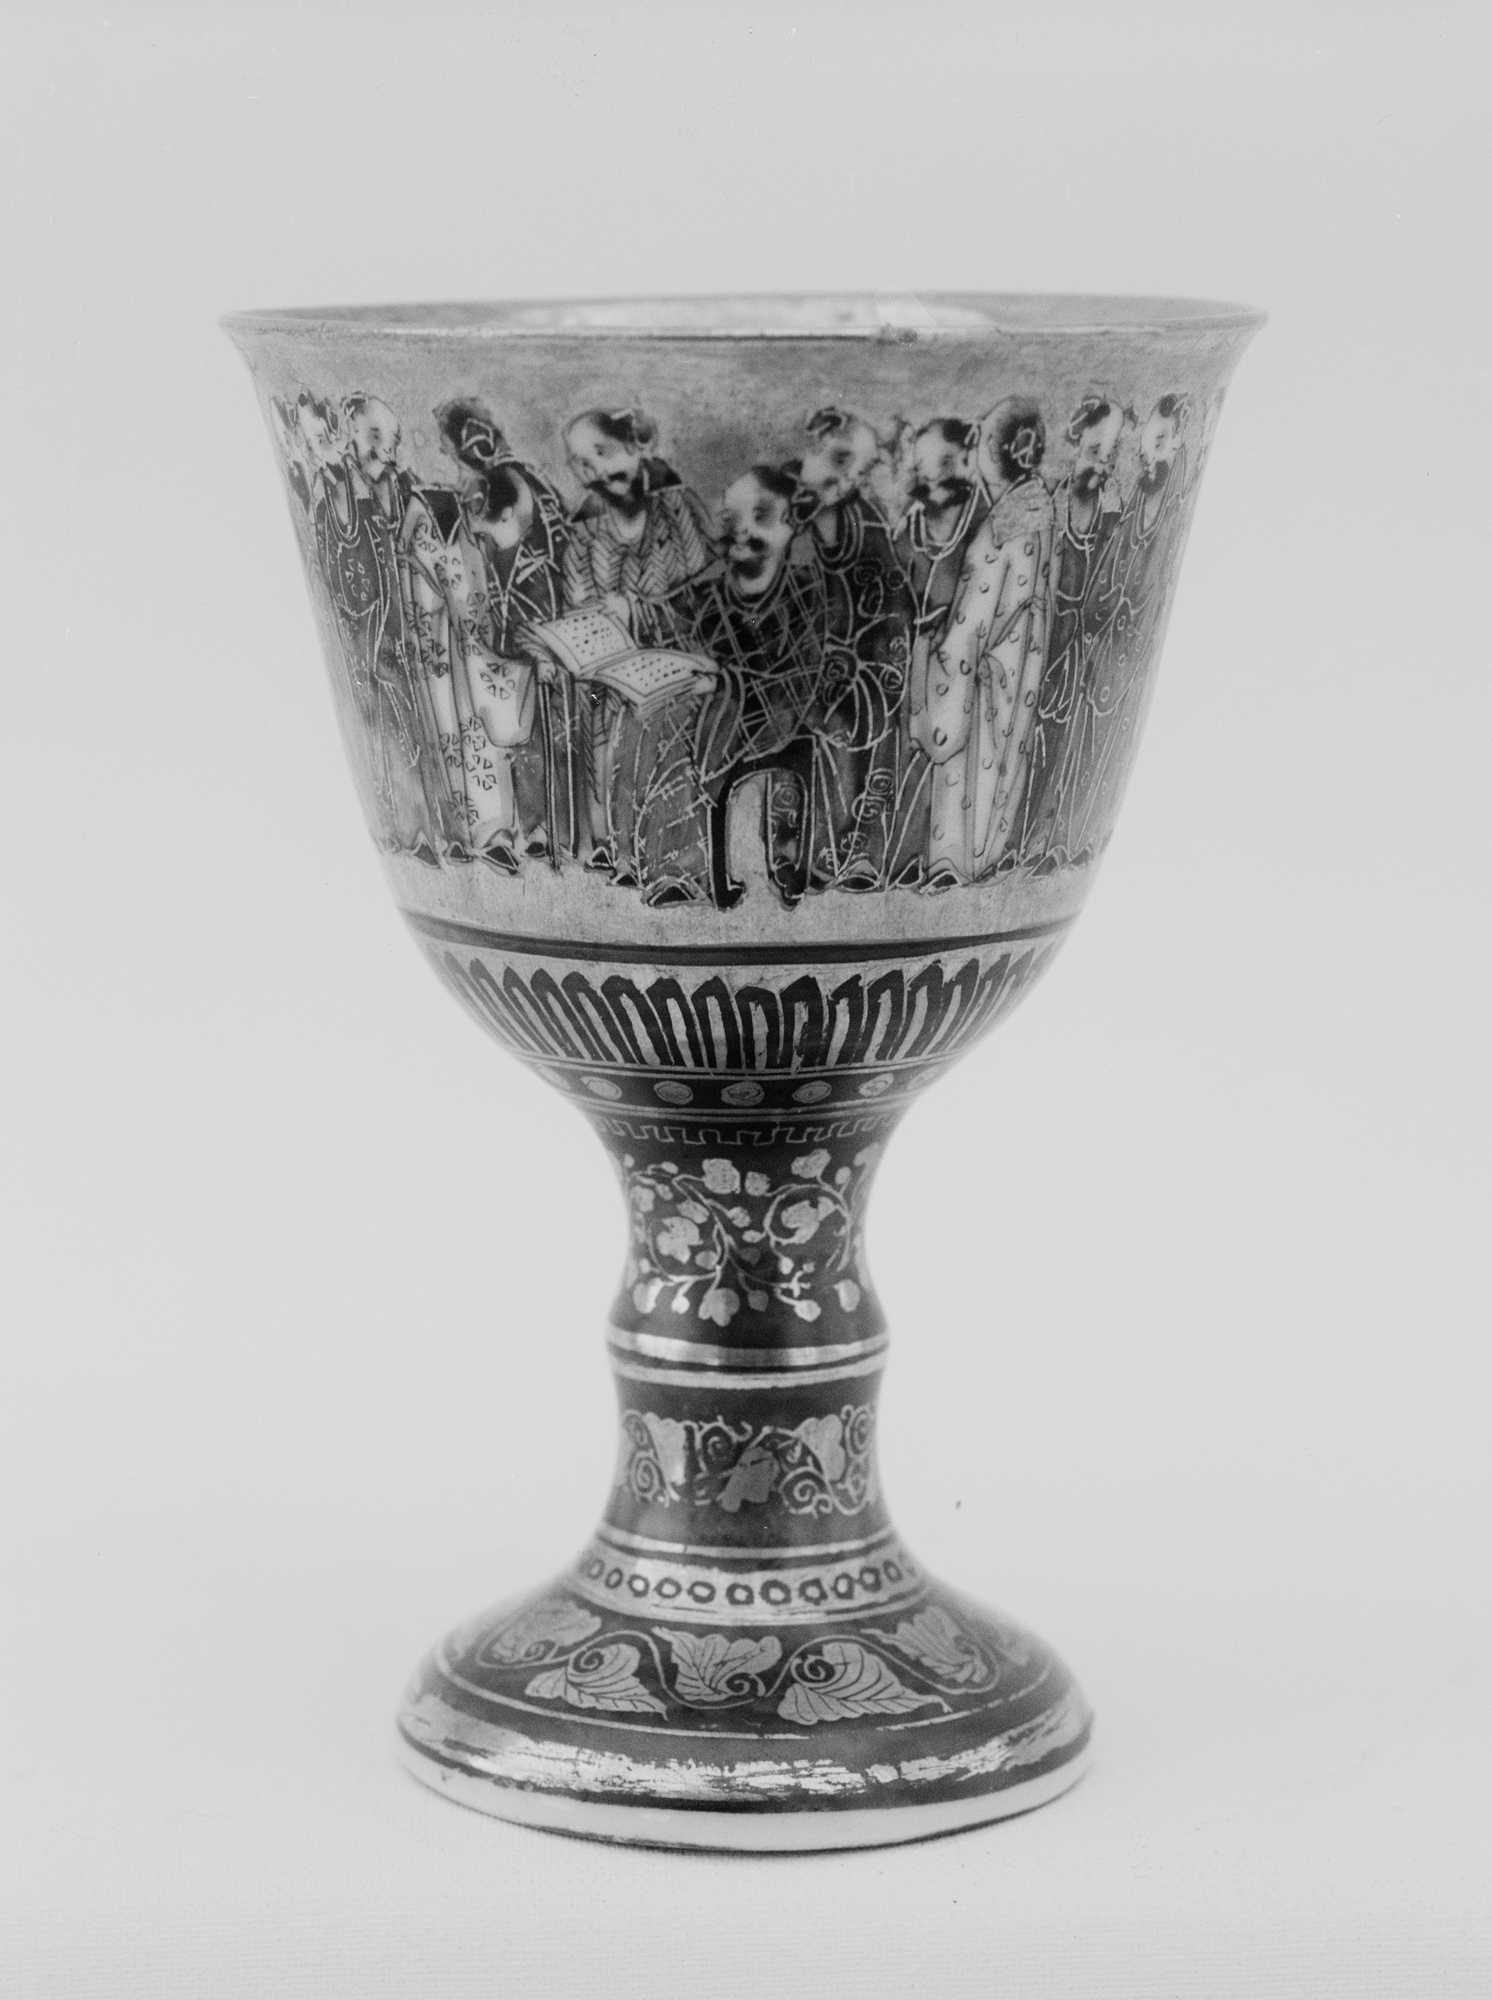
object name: cup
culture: japanese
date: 1701-1800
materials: gold, iron, porcelain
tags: men,leaves